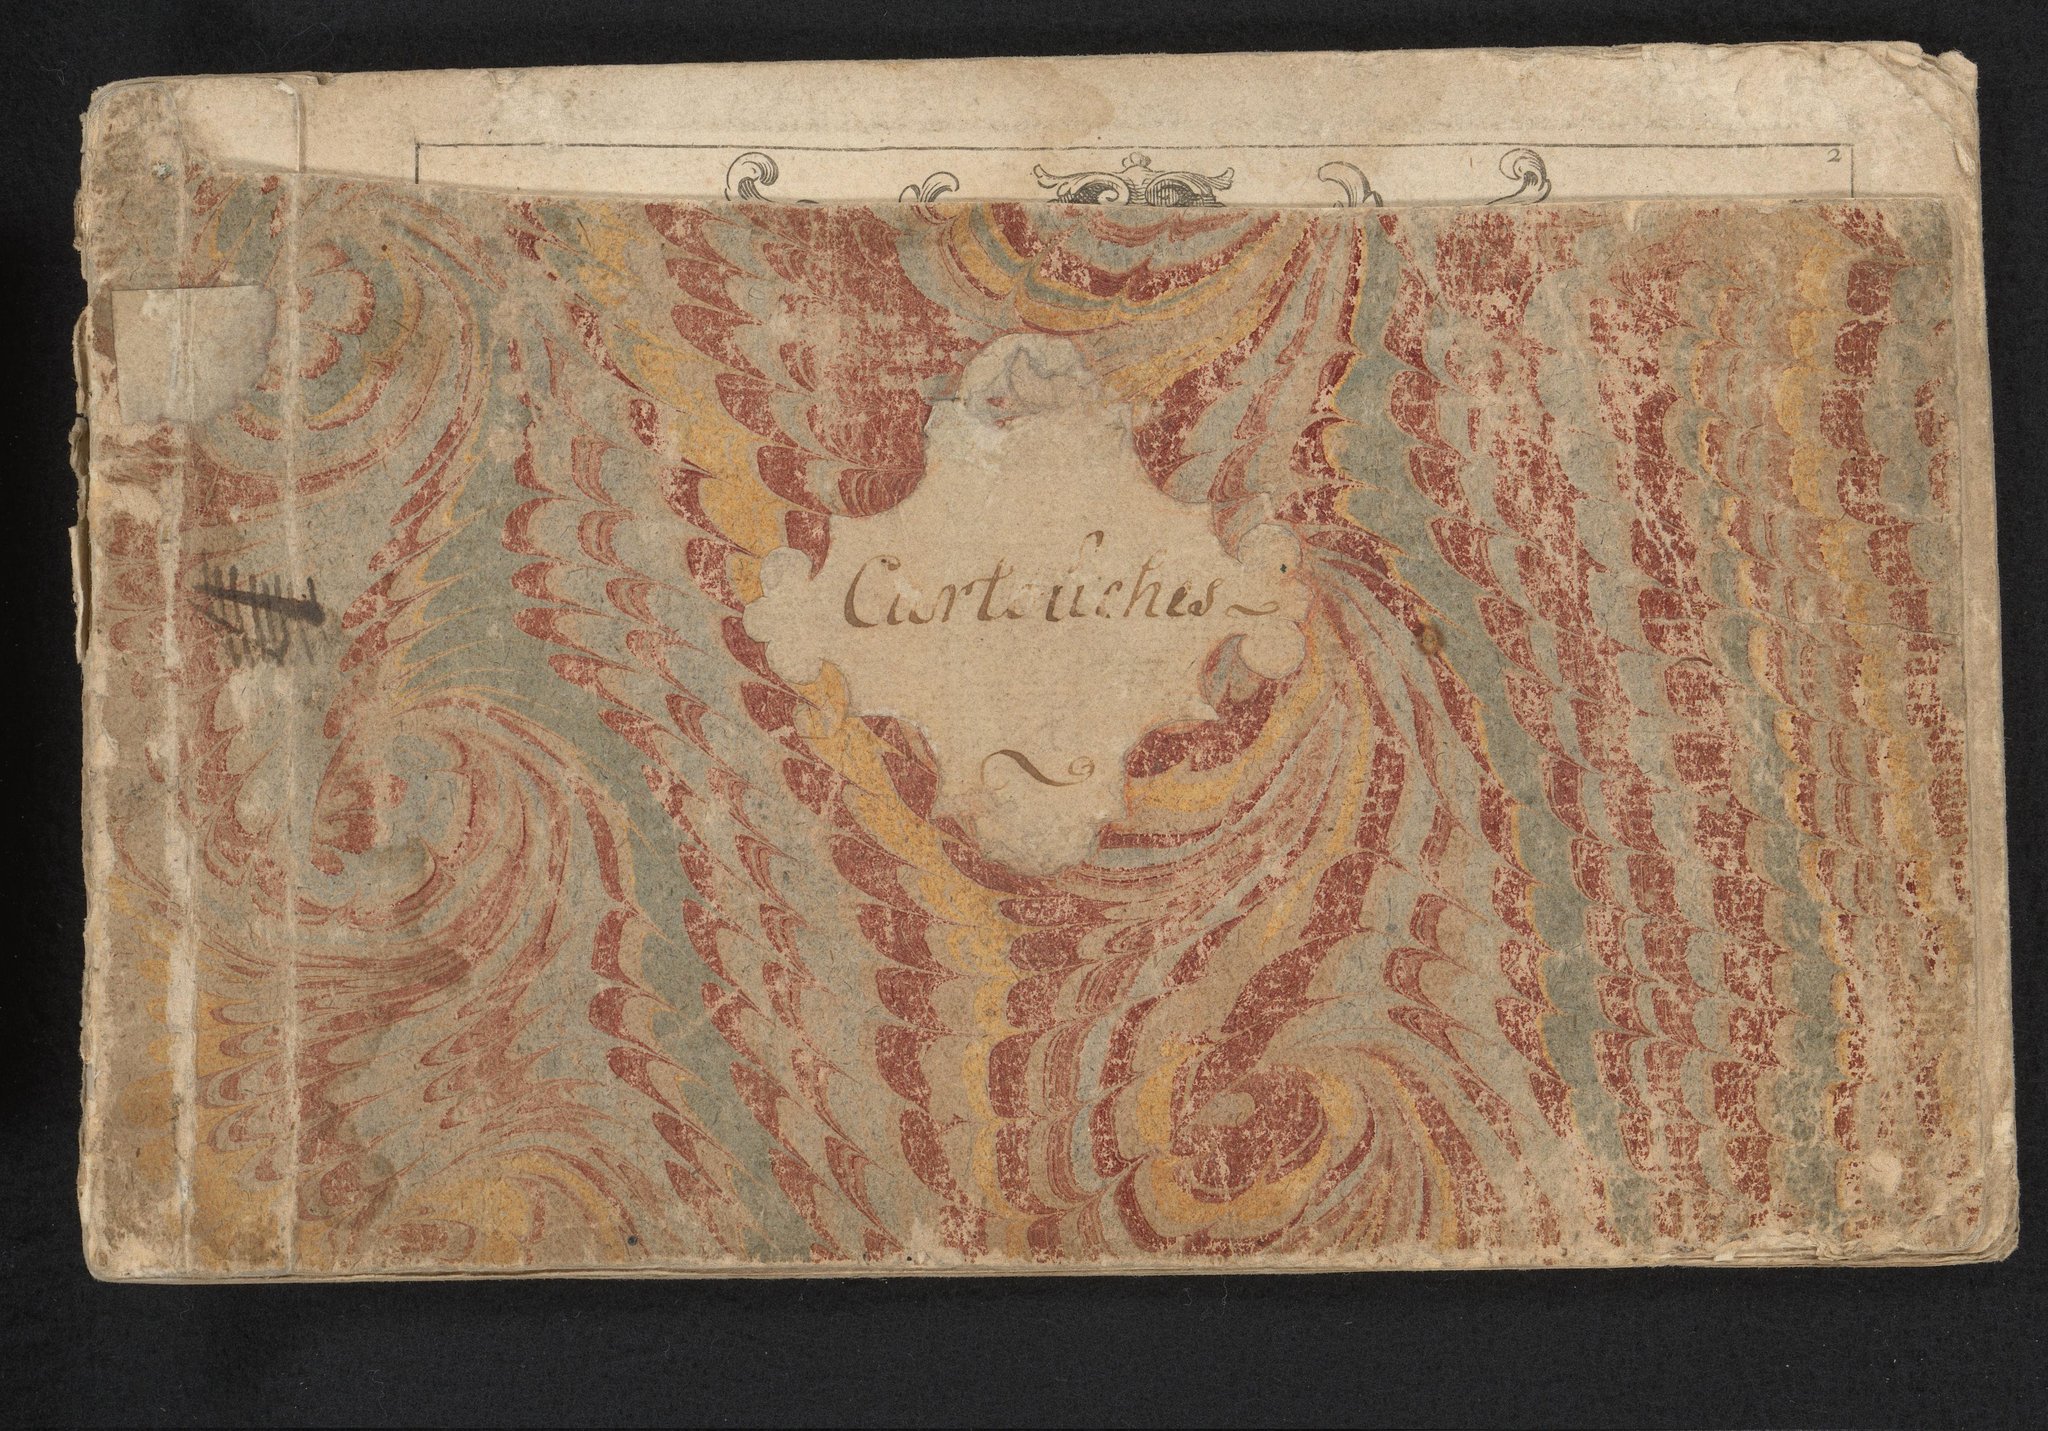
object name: prentrecueil, prentenalbum, prentalbum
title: Prentalbum met omlijstingen en cartouches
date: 1658-1719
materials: paper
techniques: marbled paper, engraving, etching, marbling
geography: paris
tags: ornament ~ cartouche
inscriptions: title: ‘Cartouches’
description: Prentalbum met een serie van zes prenten van omlijstingen en cartouches. Schrift met kaft van spiraal- en kammarmerpapier waarin prenten gebonden.